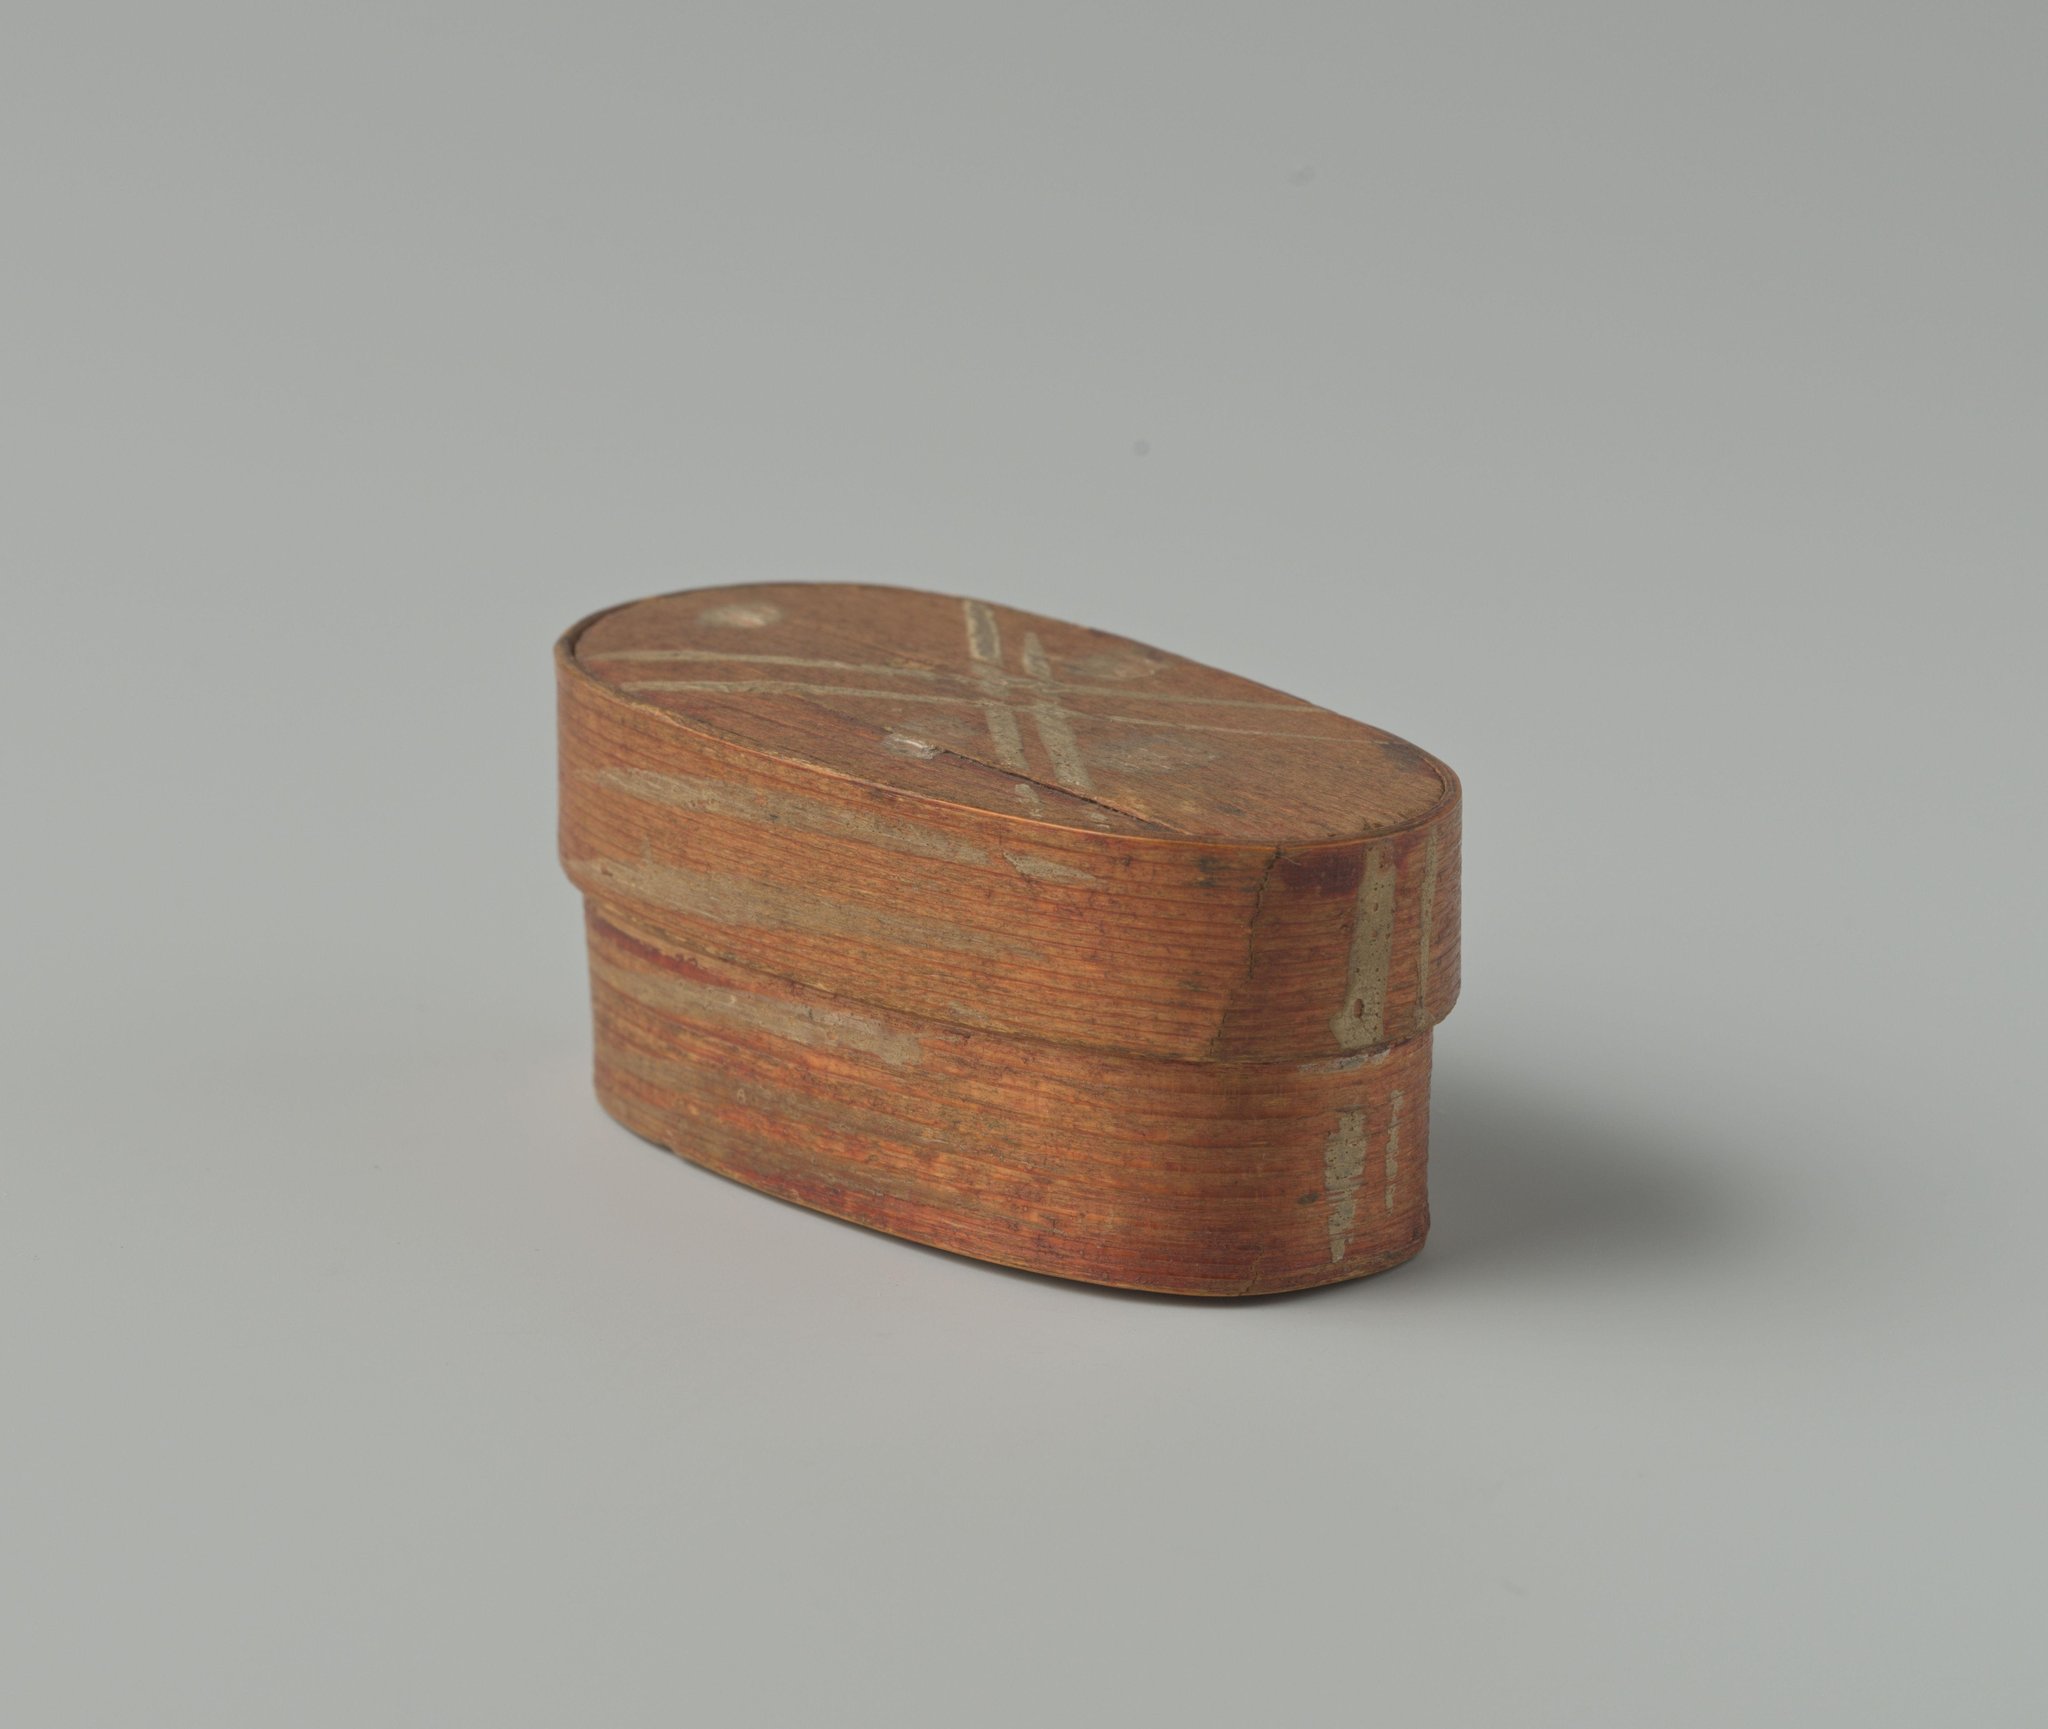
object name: miniature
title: Doos met deksel, rood, versierd met witte strepen en stippen op deksel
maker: Anonymous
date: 1650-1750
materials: wood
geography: amsterdam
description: De ovalen doos is gemaakt van spanen van grenenhout, roodgekleurd en versierd met witte strepen en stippen op het deksel.